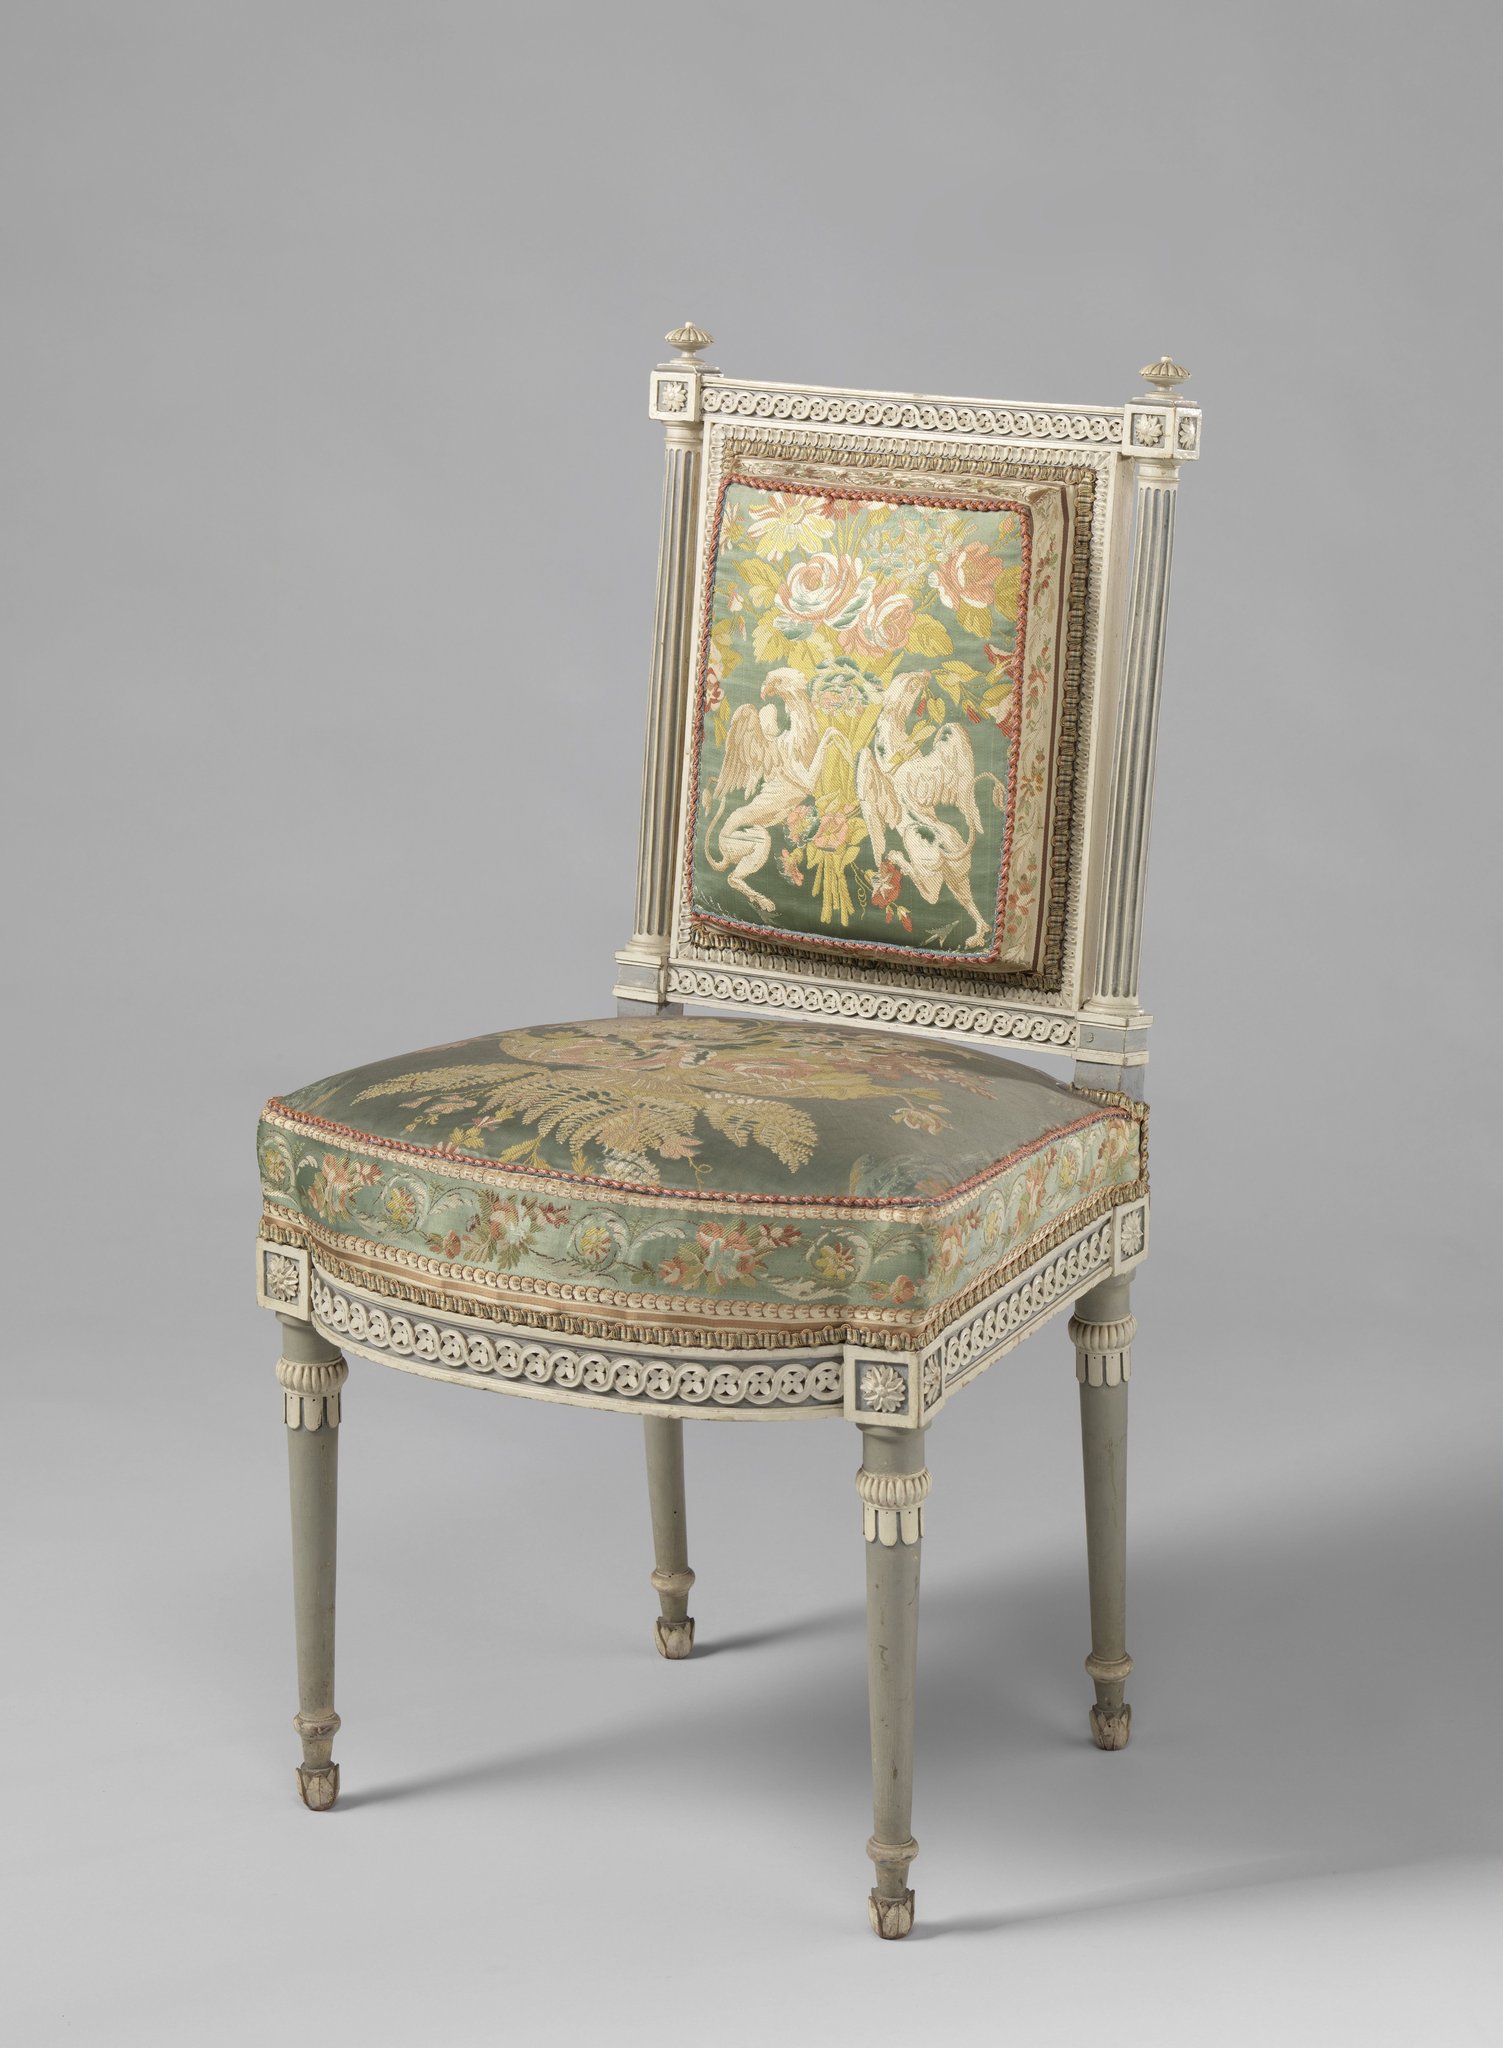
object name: suite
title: Stoel Kops-ameublement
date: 1793-1795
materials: wood, silk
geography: low countries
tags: griffin (lion/eagle); 'griffo' (ripa), flowers ~ ornament